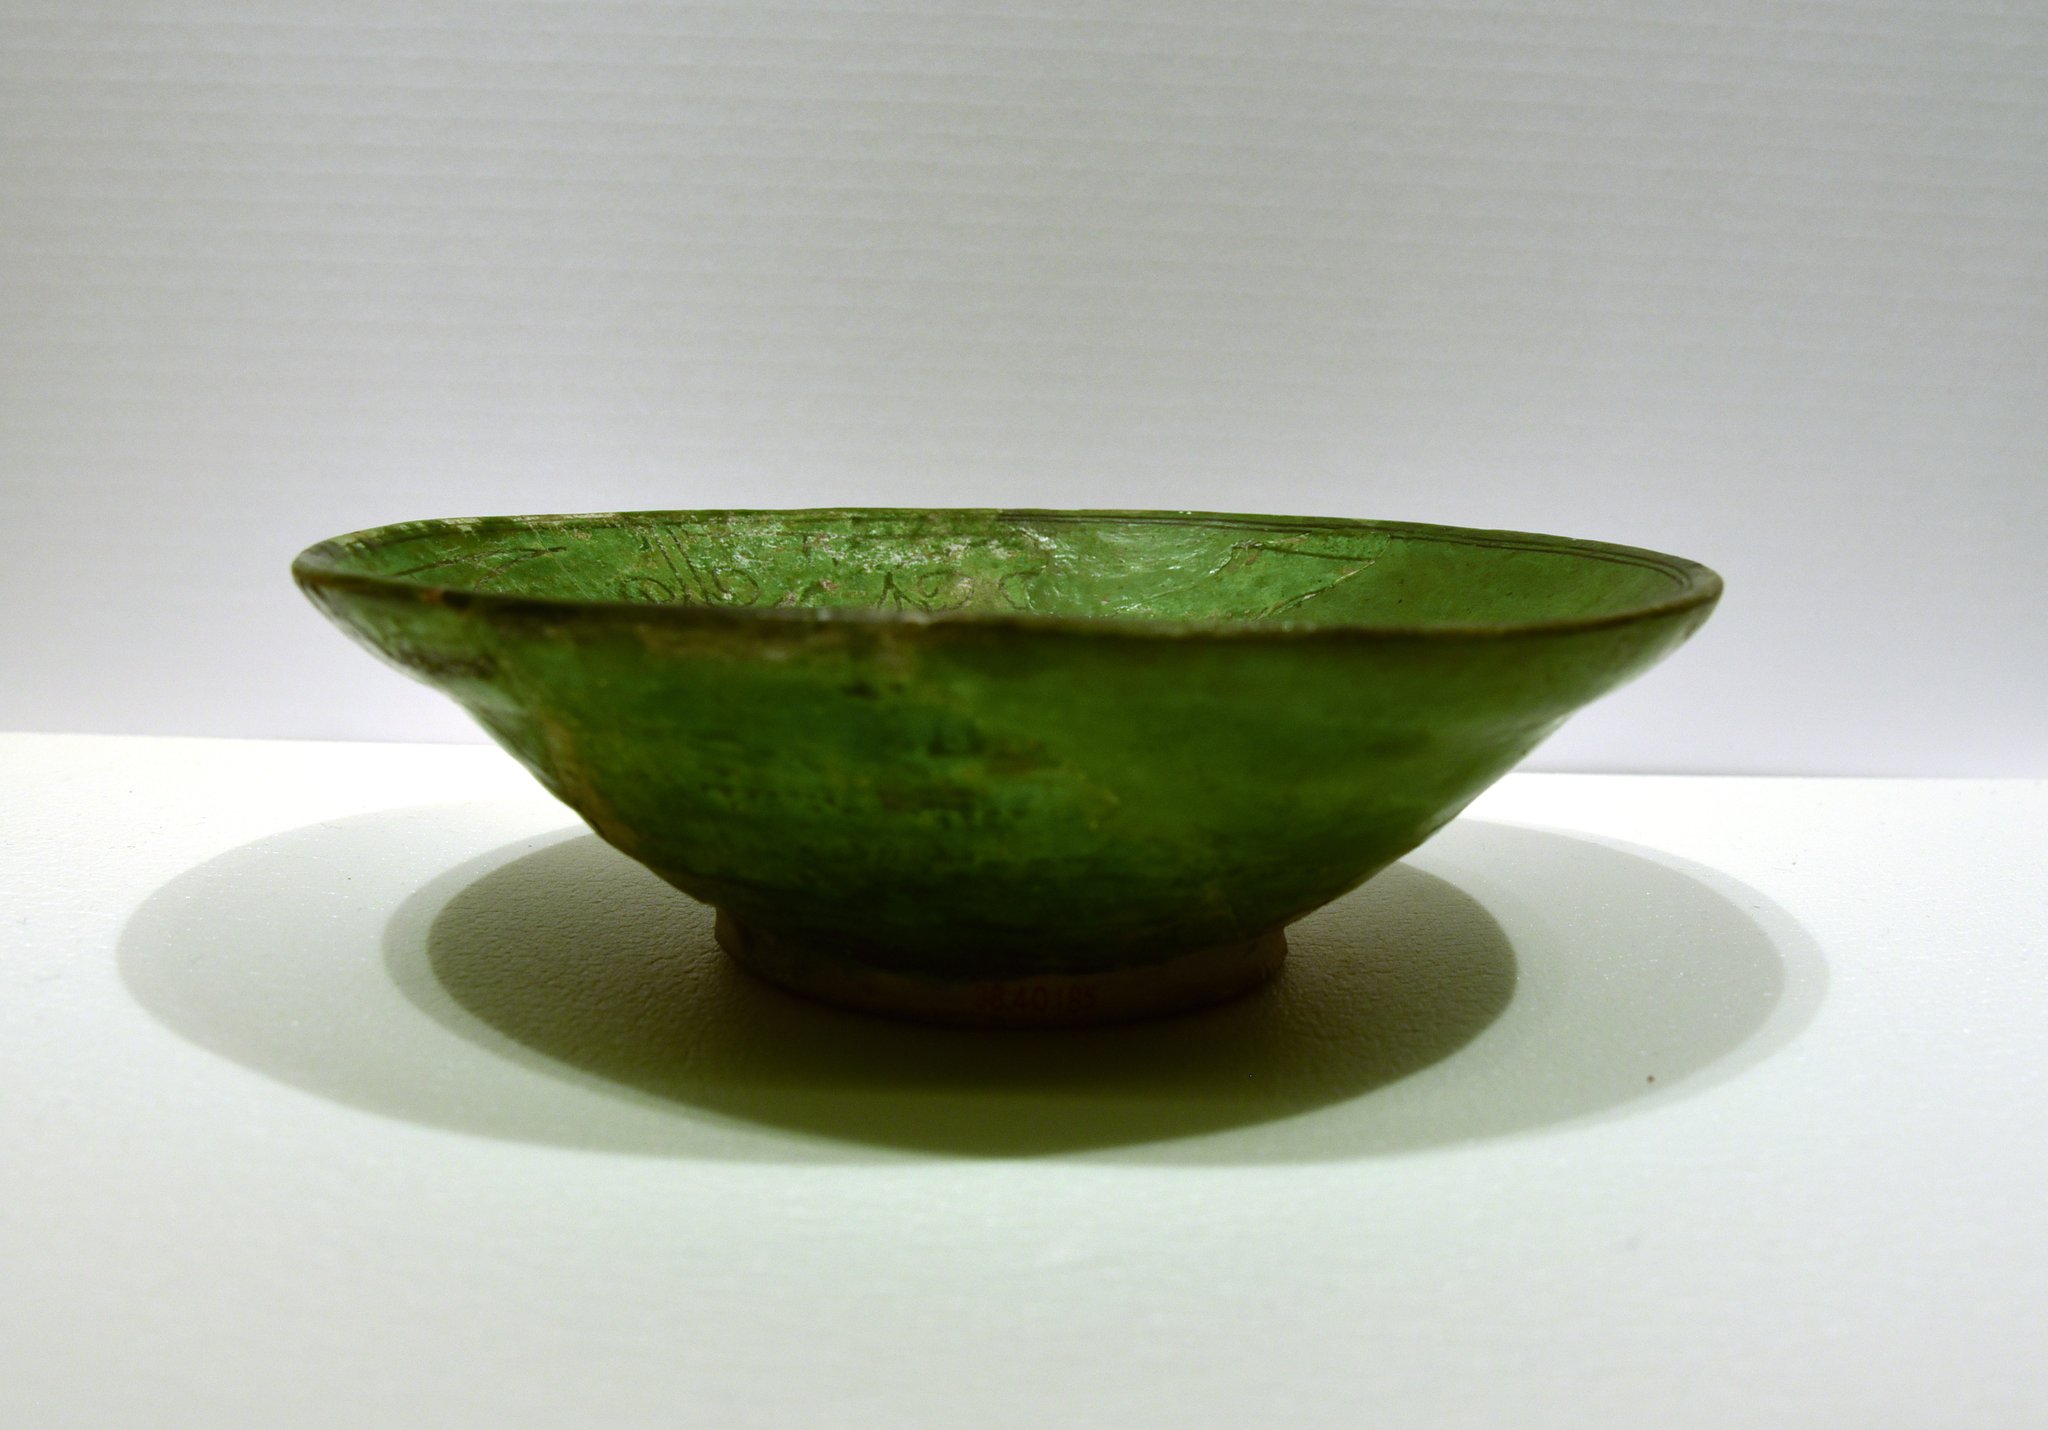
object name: bowl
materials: earthenware, glaze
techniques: incising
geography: iran